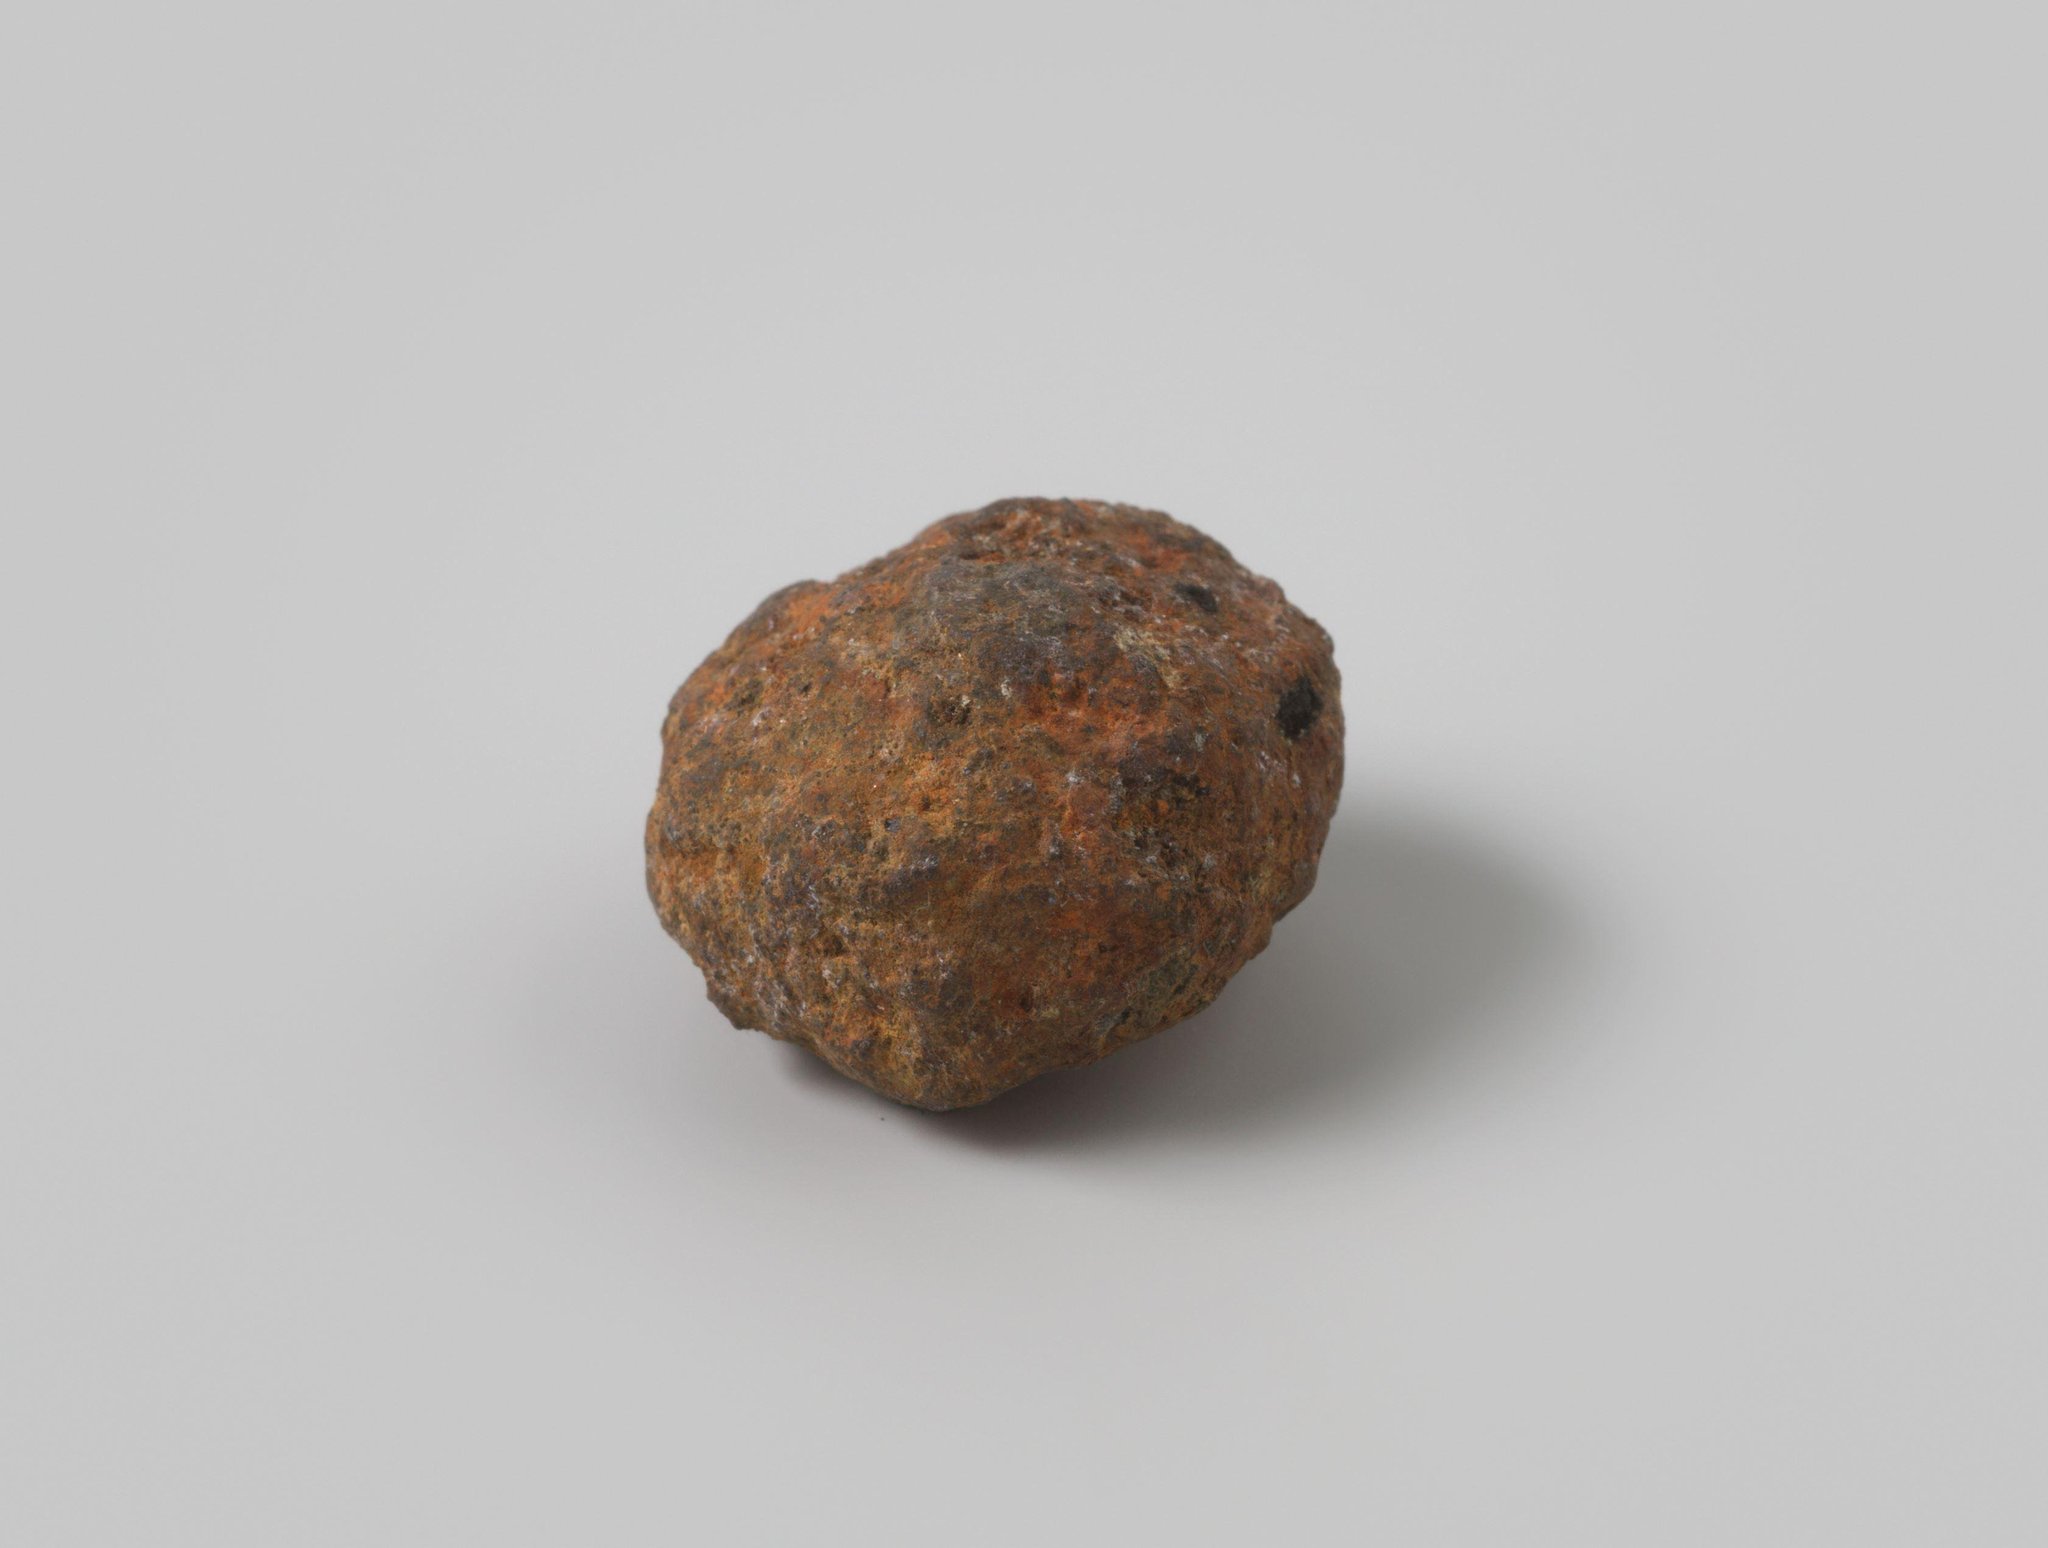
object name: musketkogel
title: Musketkogel uit het wrak van de Oost-Indiëvaarder Hollandia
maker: Anonymous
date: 1700-1743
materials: lead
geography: netherlands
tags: verenigde oostindische compagnie, hollandia (schip), annet